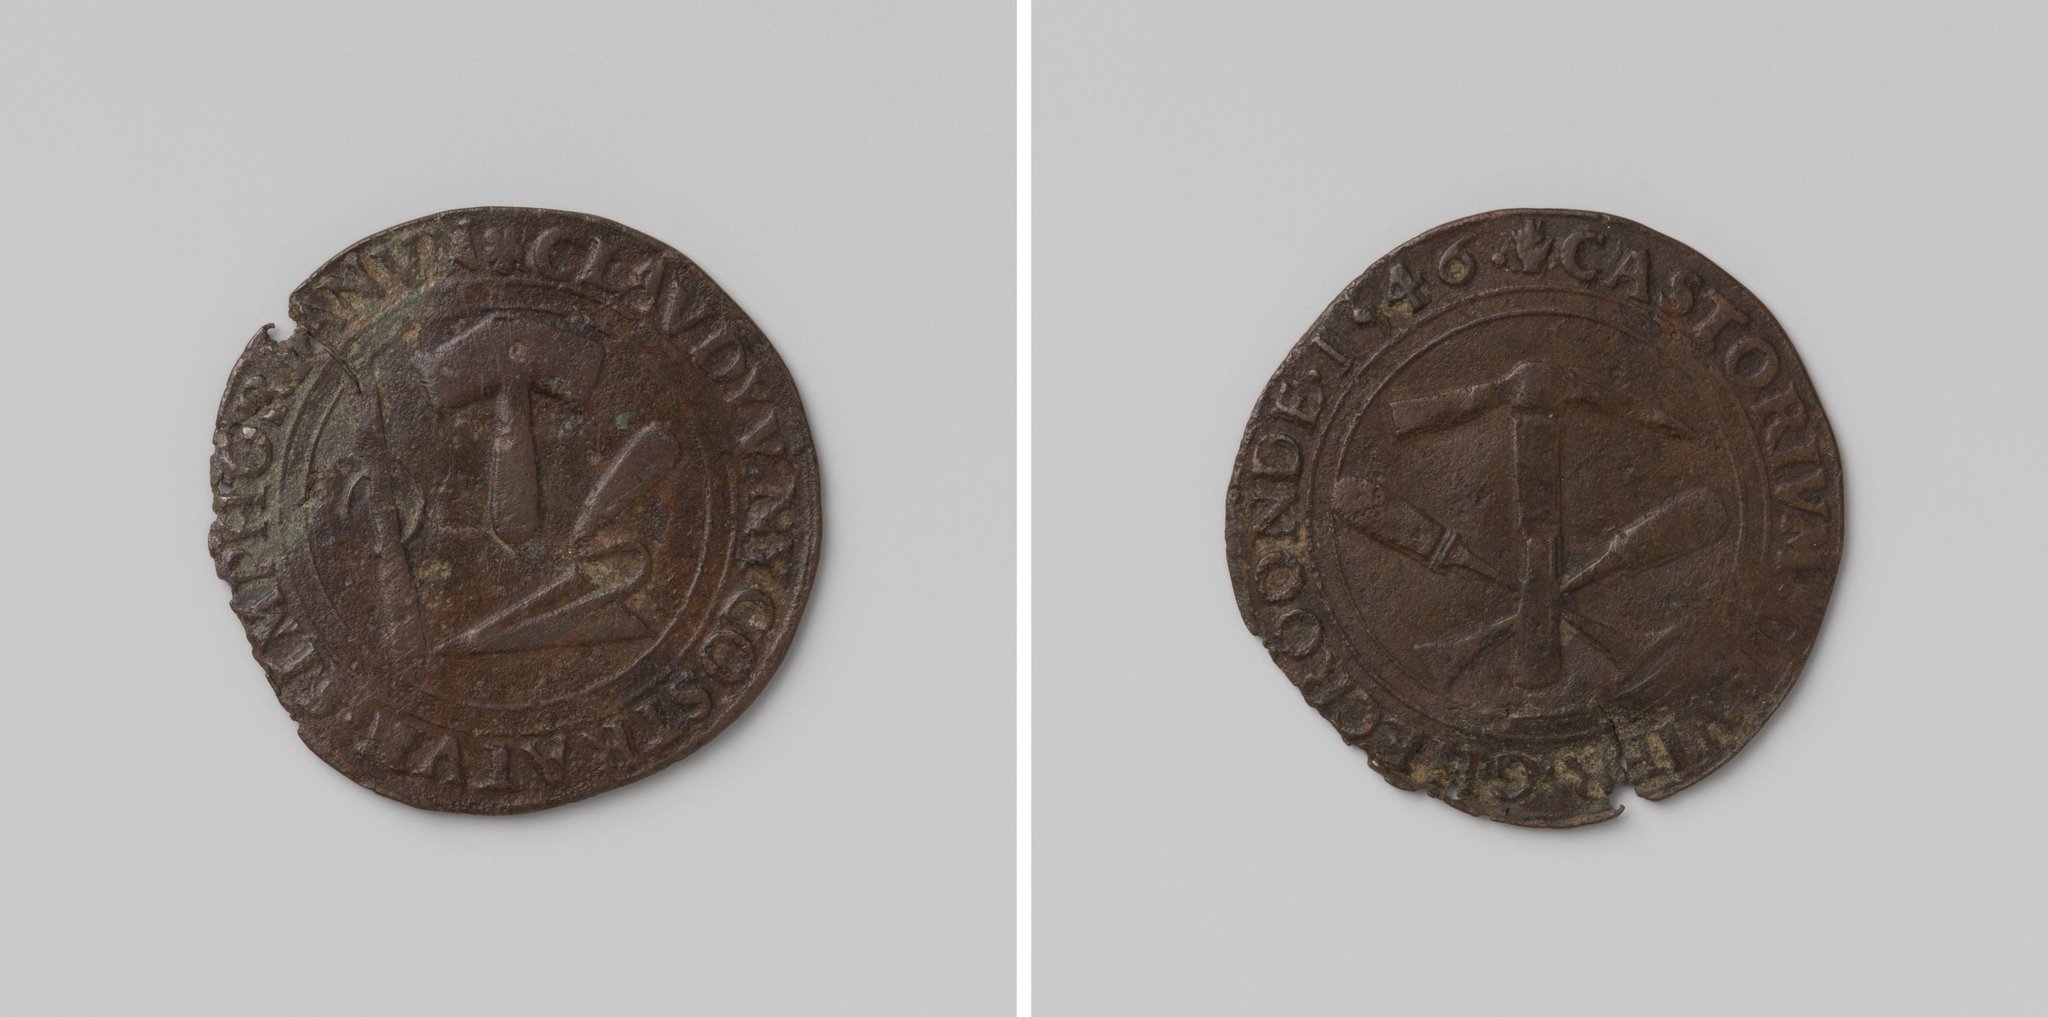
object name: medal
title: Metselaars- en steenhouwersgilde van Antwerpen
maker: Anonymous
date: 1546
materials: copper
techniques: striking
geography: antwerp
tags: antwerp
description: Koperen penning. Voorzijde: hamer, troffel en langwerpig voorwerp binnen omschrift. Keerzijde: hamer voor twee gekruiste beitels binnen omschrift